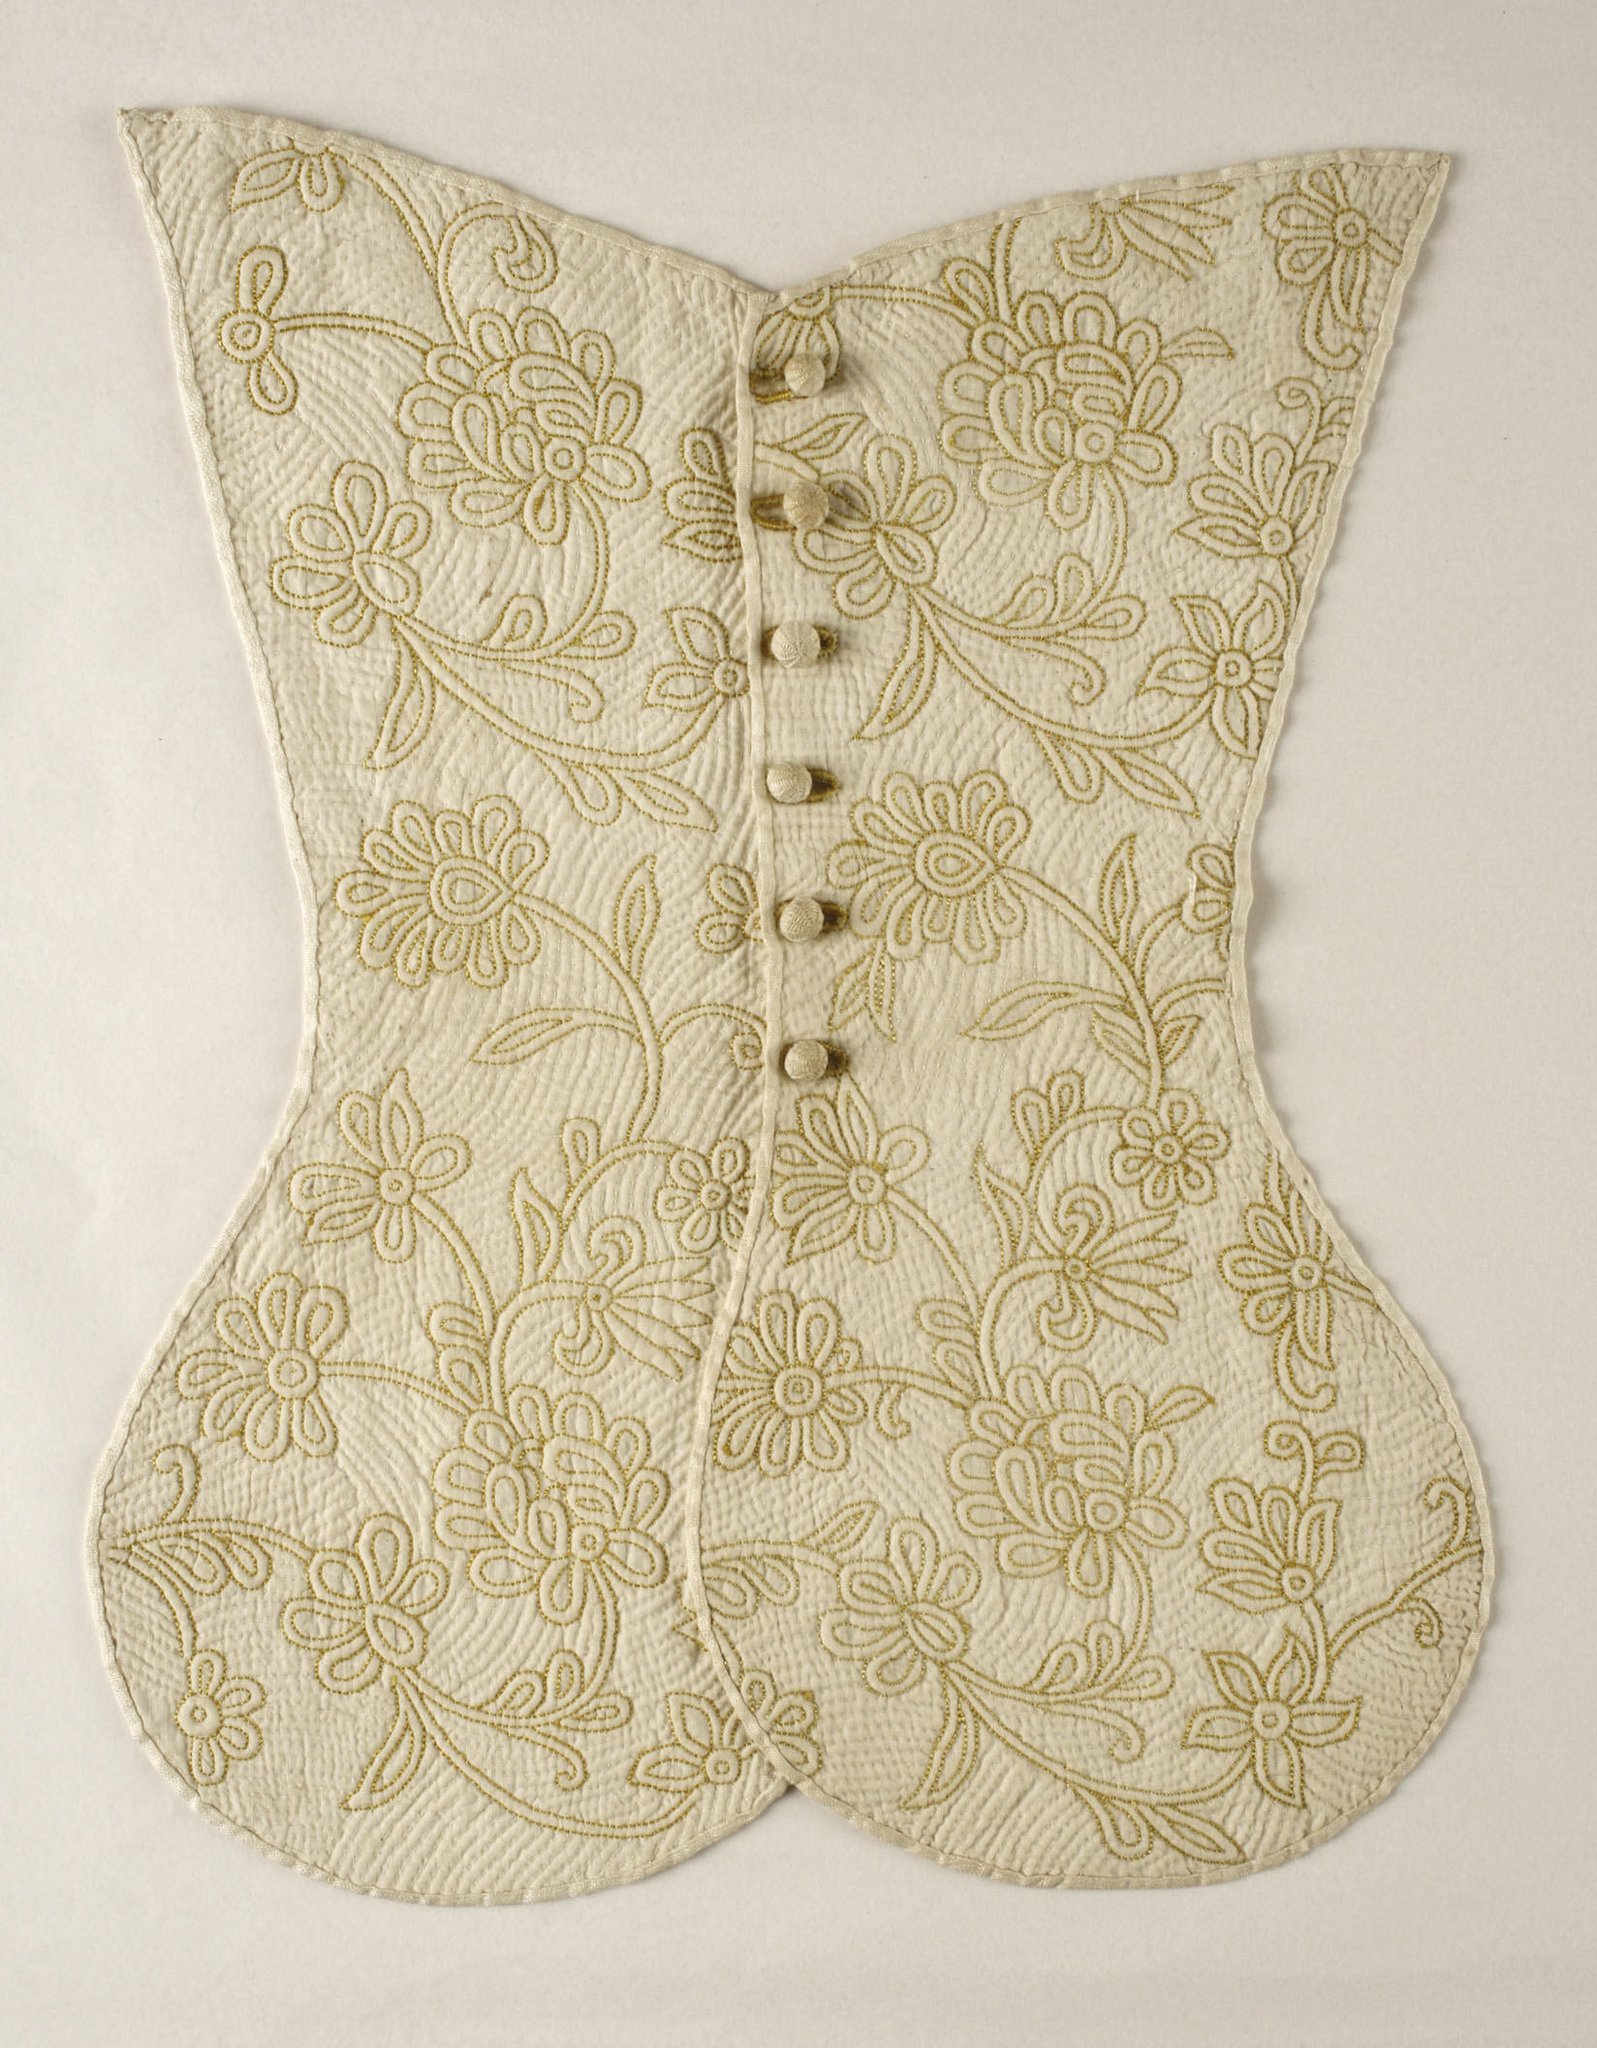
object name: stomacher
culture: british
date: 1720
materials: linen, silk